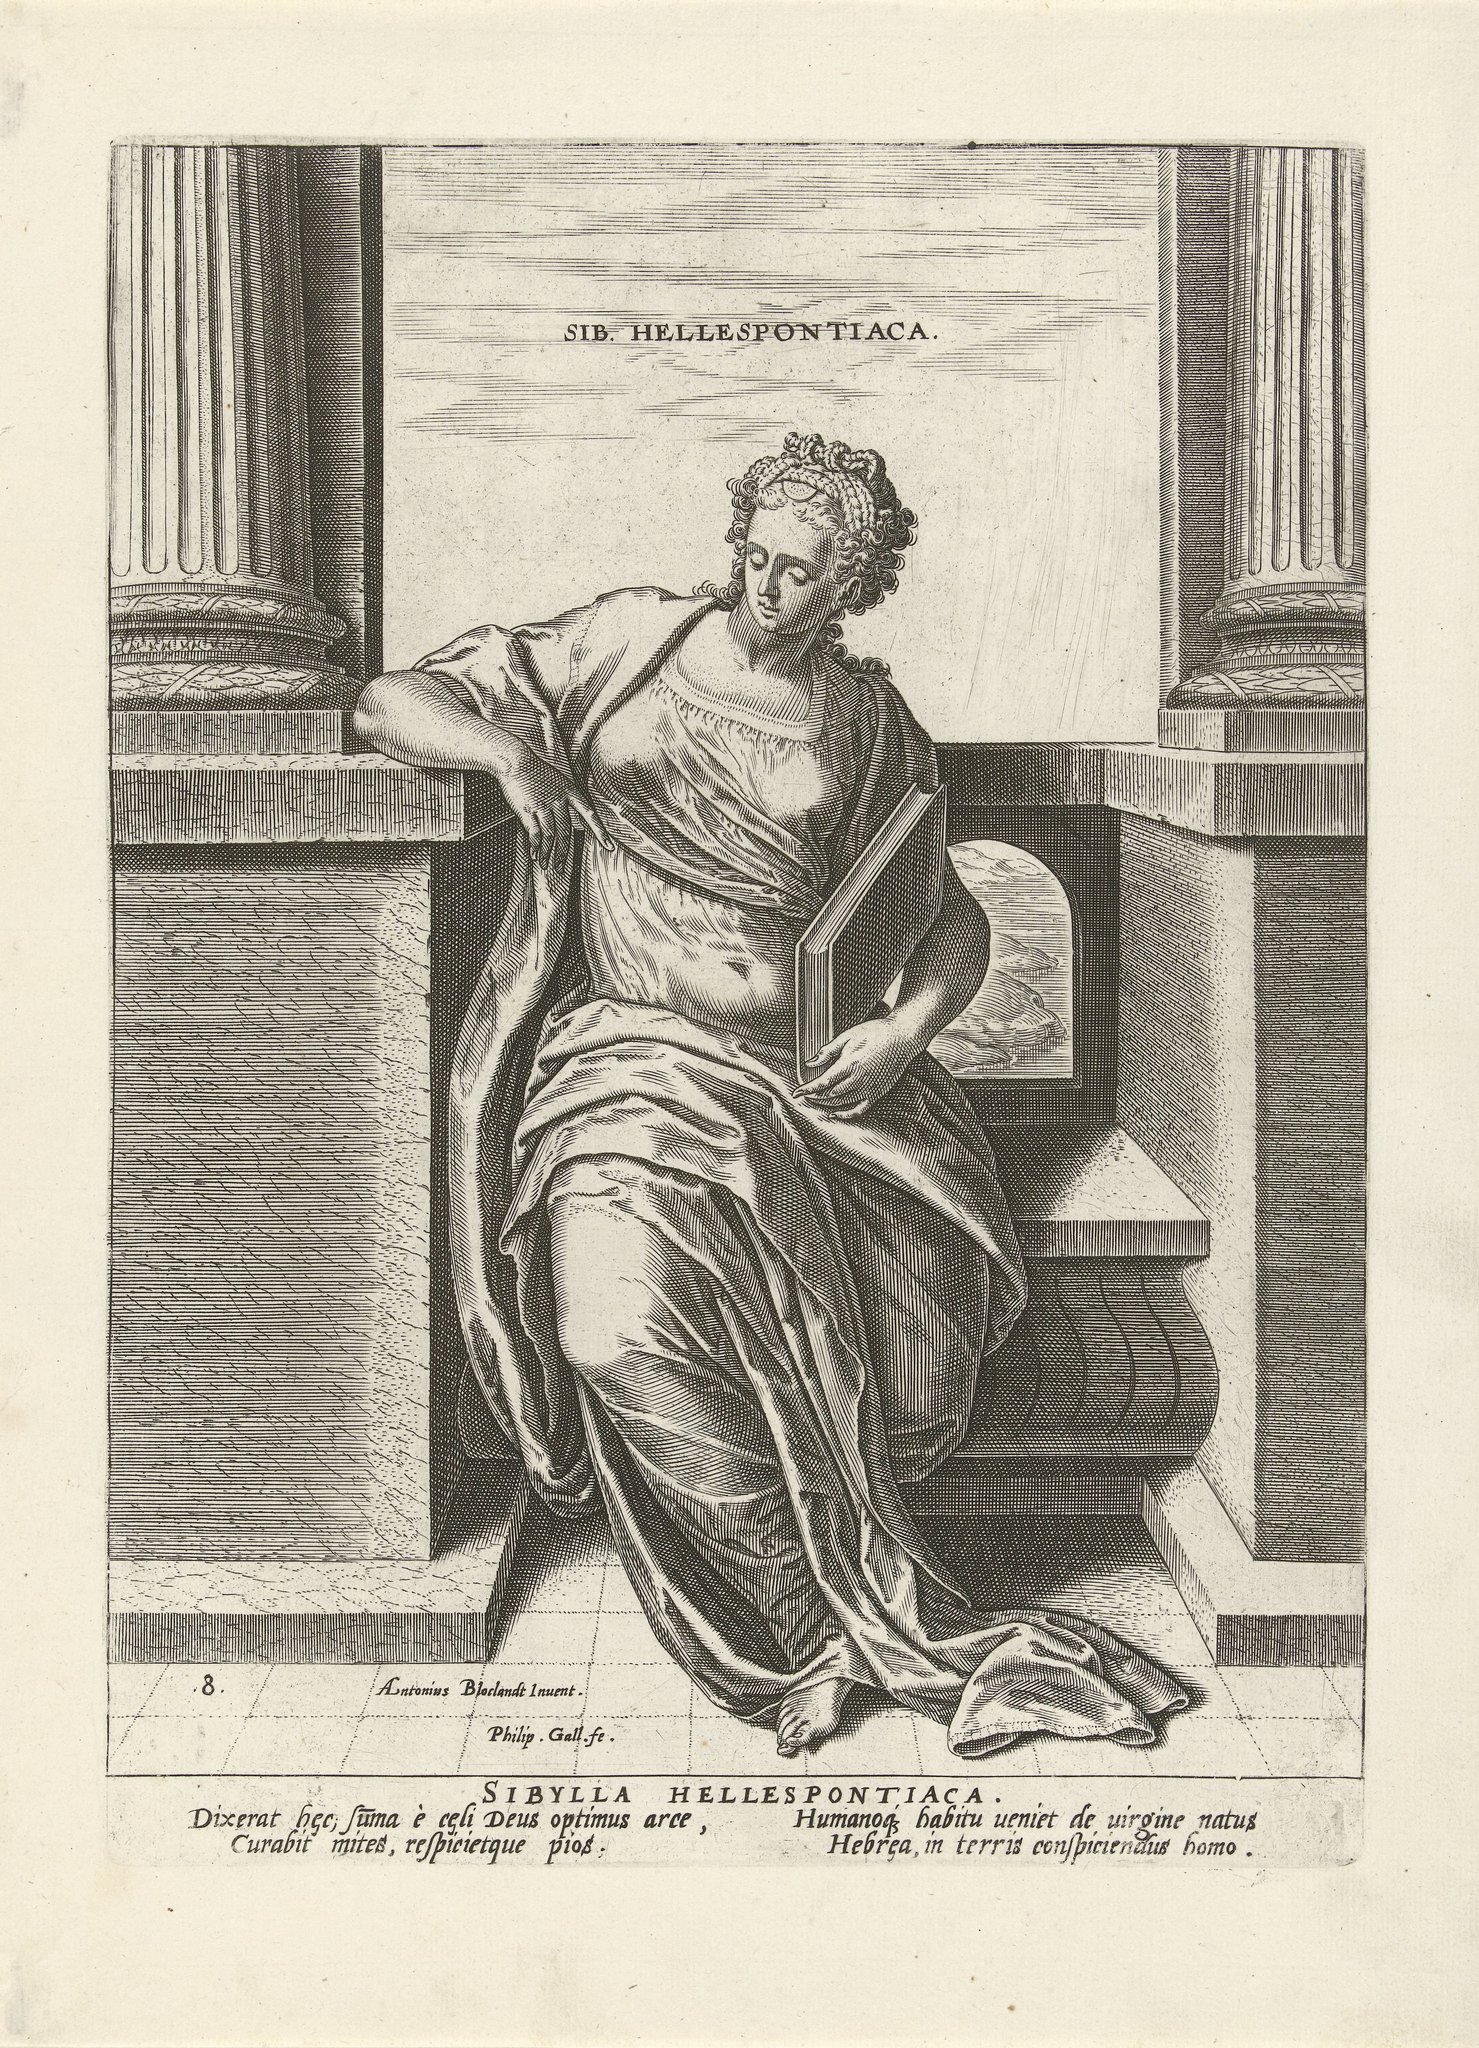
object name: print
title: Hellespontische Sibille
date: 1575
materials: paper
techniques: engraving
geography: antwerp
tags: sibyls (with name)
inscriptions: collector's mark: Lugt 2228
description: De Hellespontische Sibille zit op een stenen bankje. Ze heeft een boek vast. De prent heeft een Latijns onderschrift en maakt deel uit van een tiendelige serie over de Sibillen.